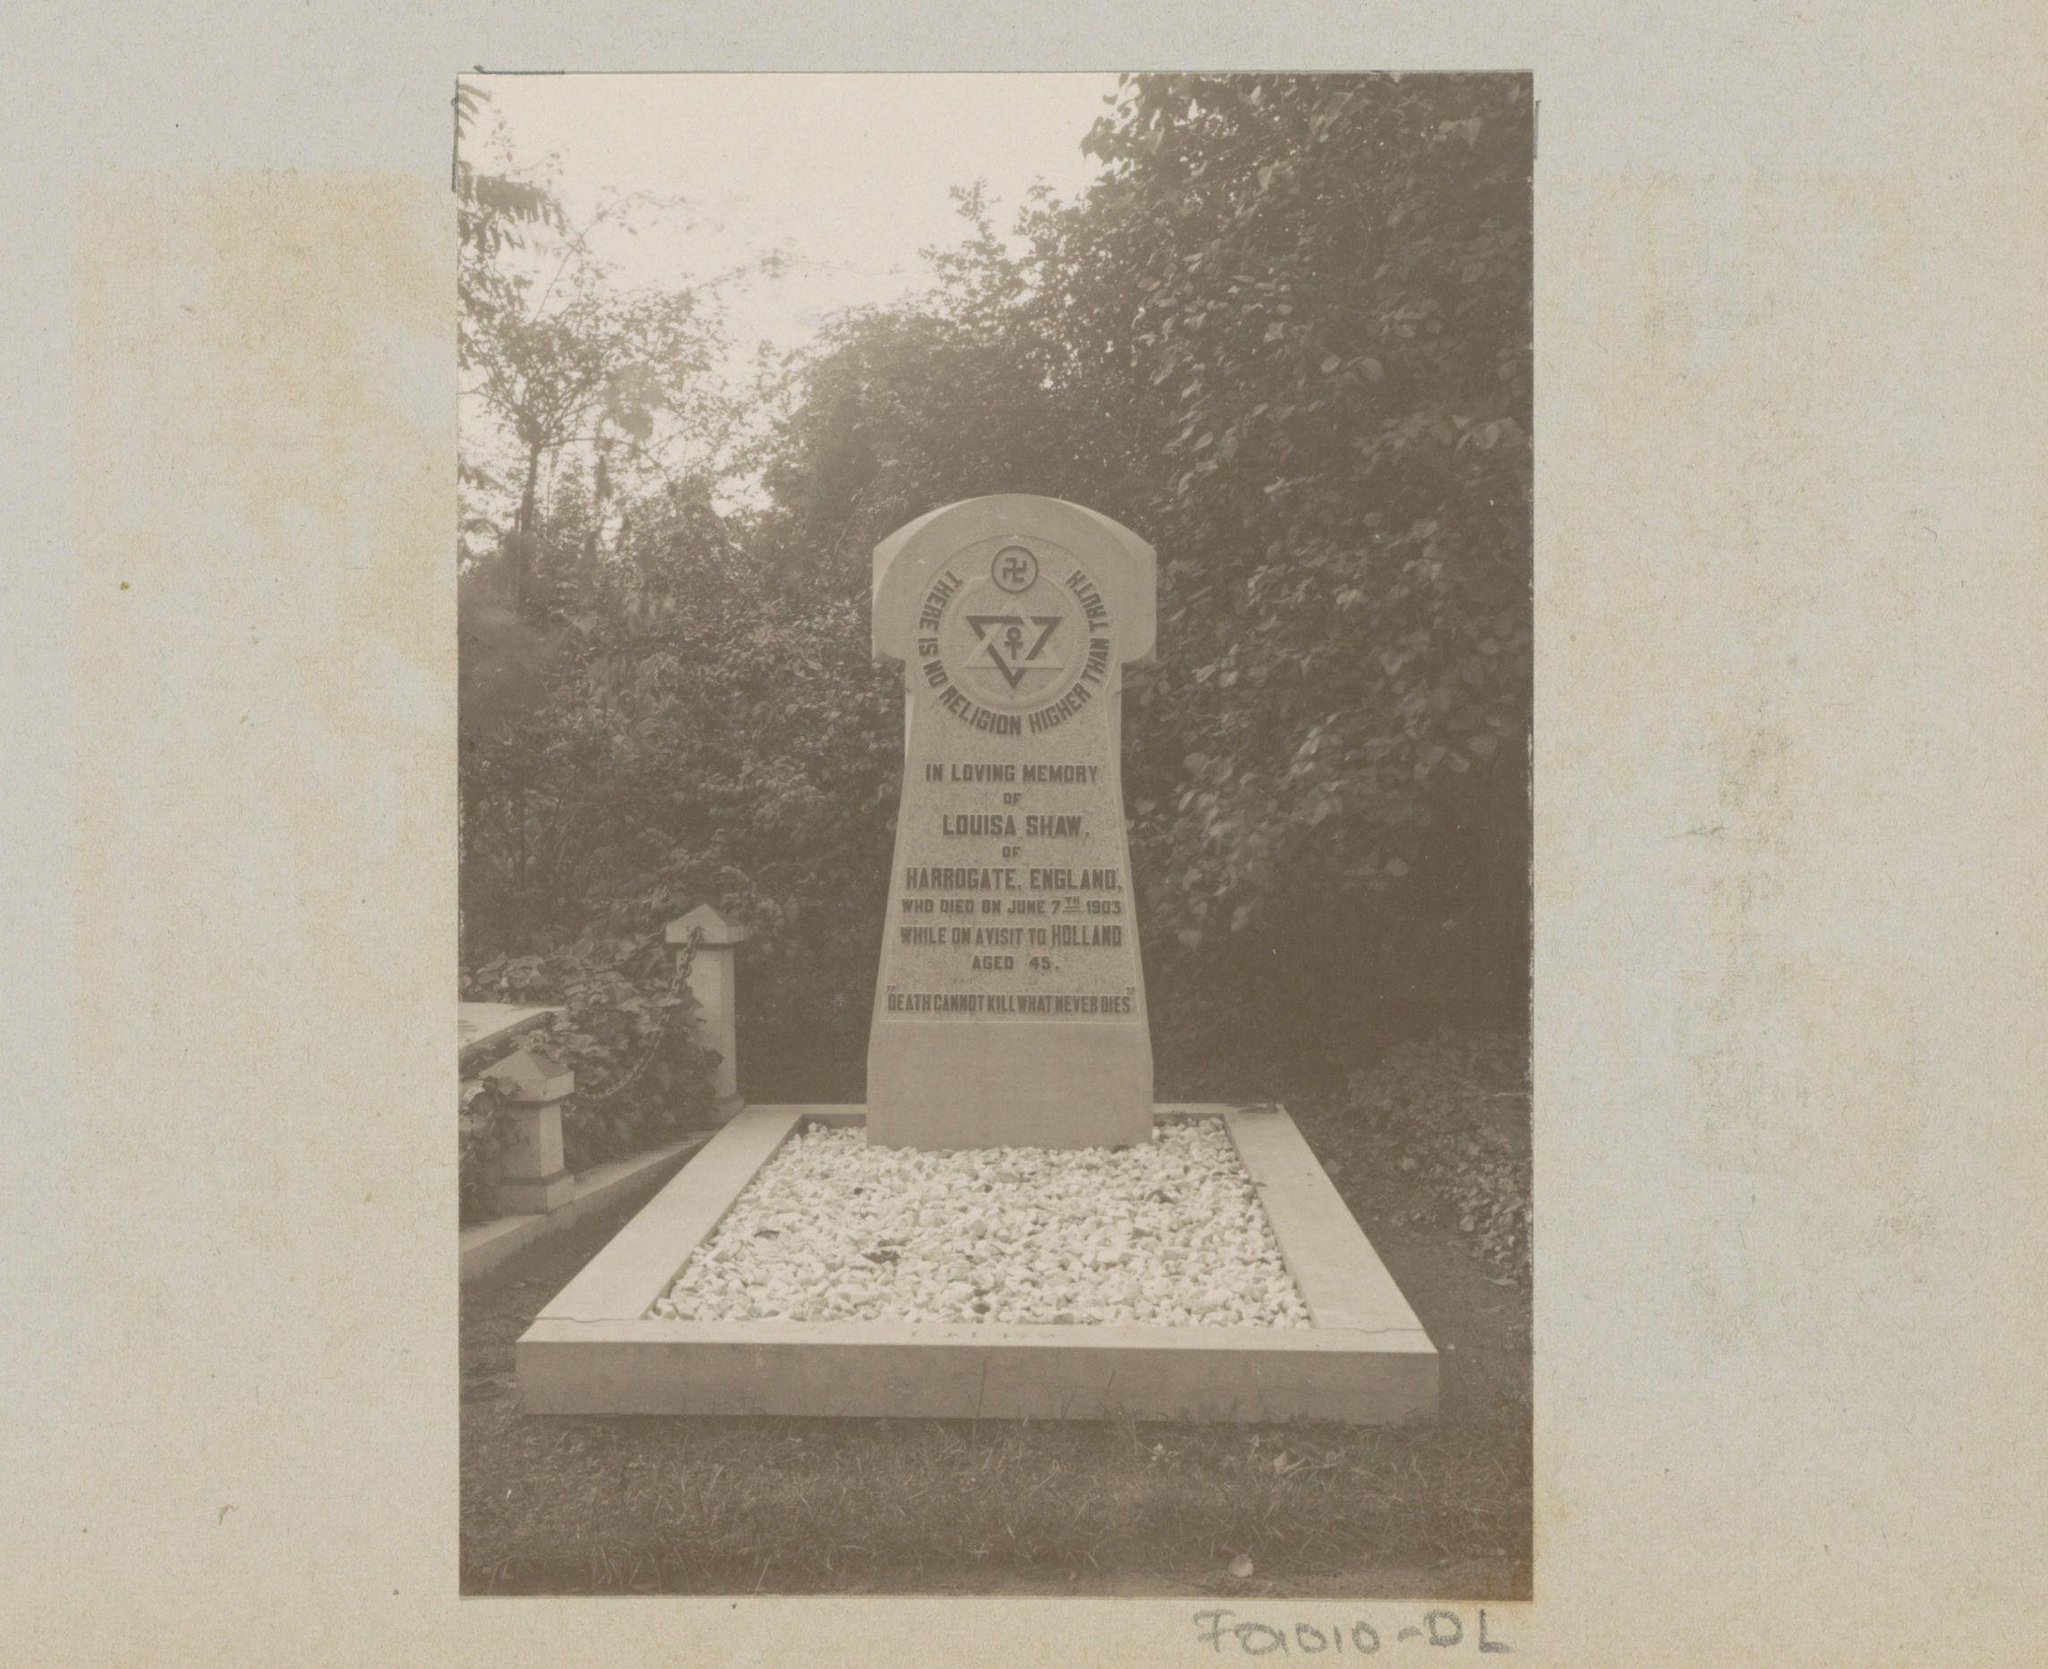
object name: photograph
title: Grafmonument van Louisa Shaw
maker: Anonymous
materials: photographic support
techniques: matte daylight collodion silver print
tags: grave, tomb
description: Onderdeel van Familiealbum met onder meer foto's van Wijnhandel Kraaij & Co. Bordeaux-Amsterdam.